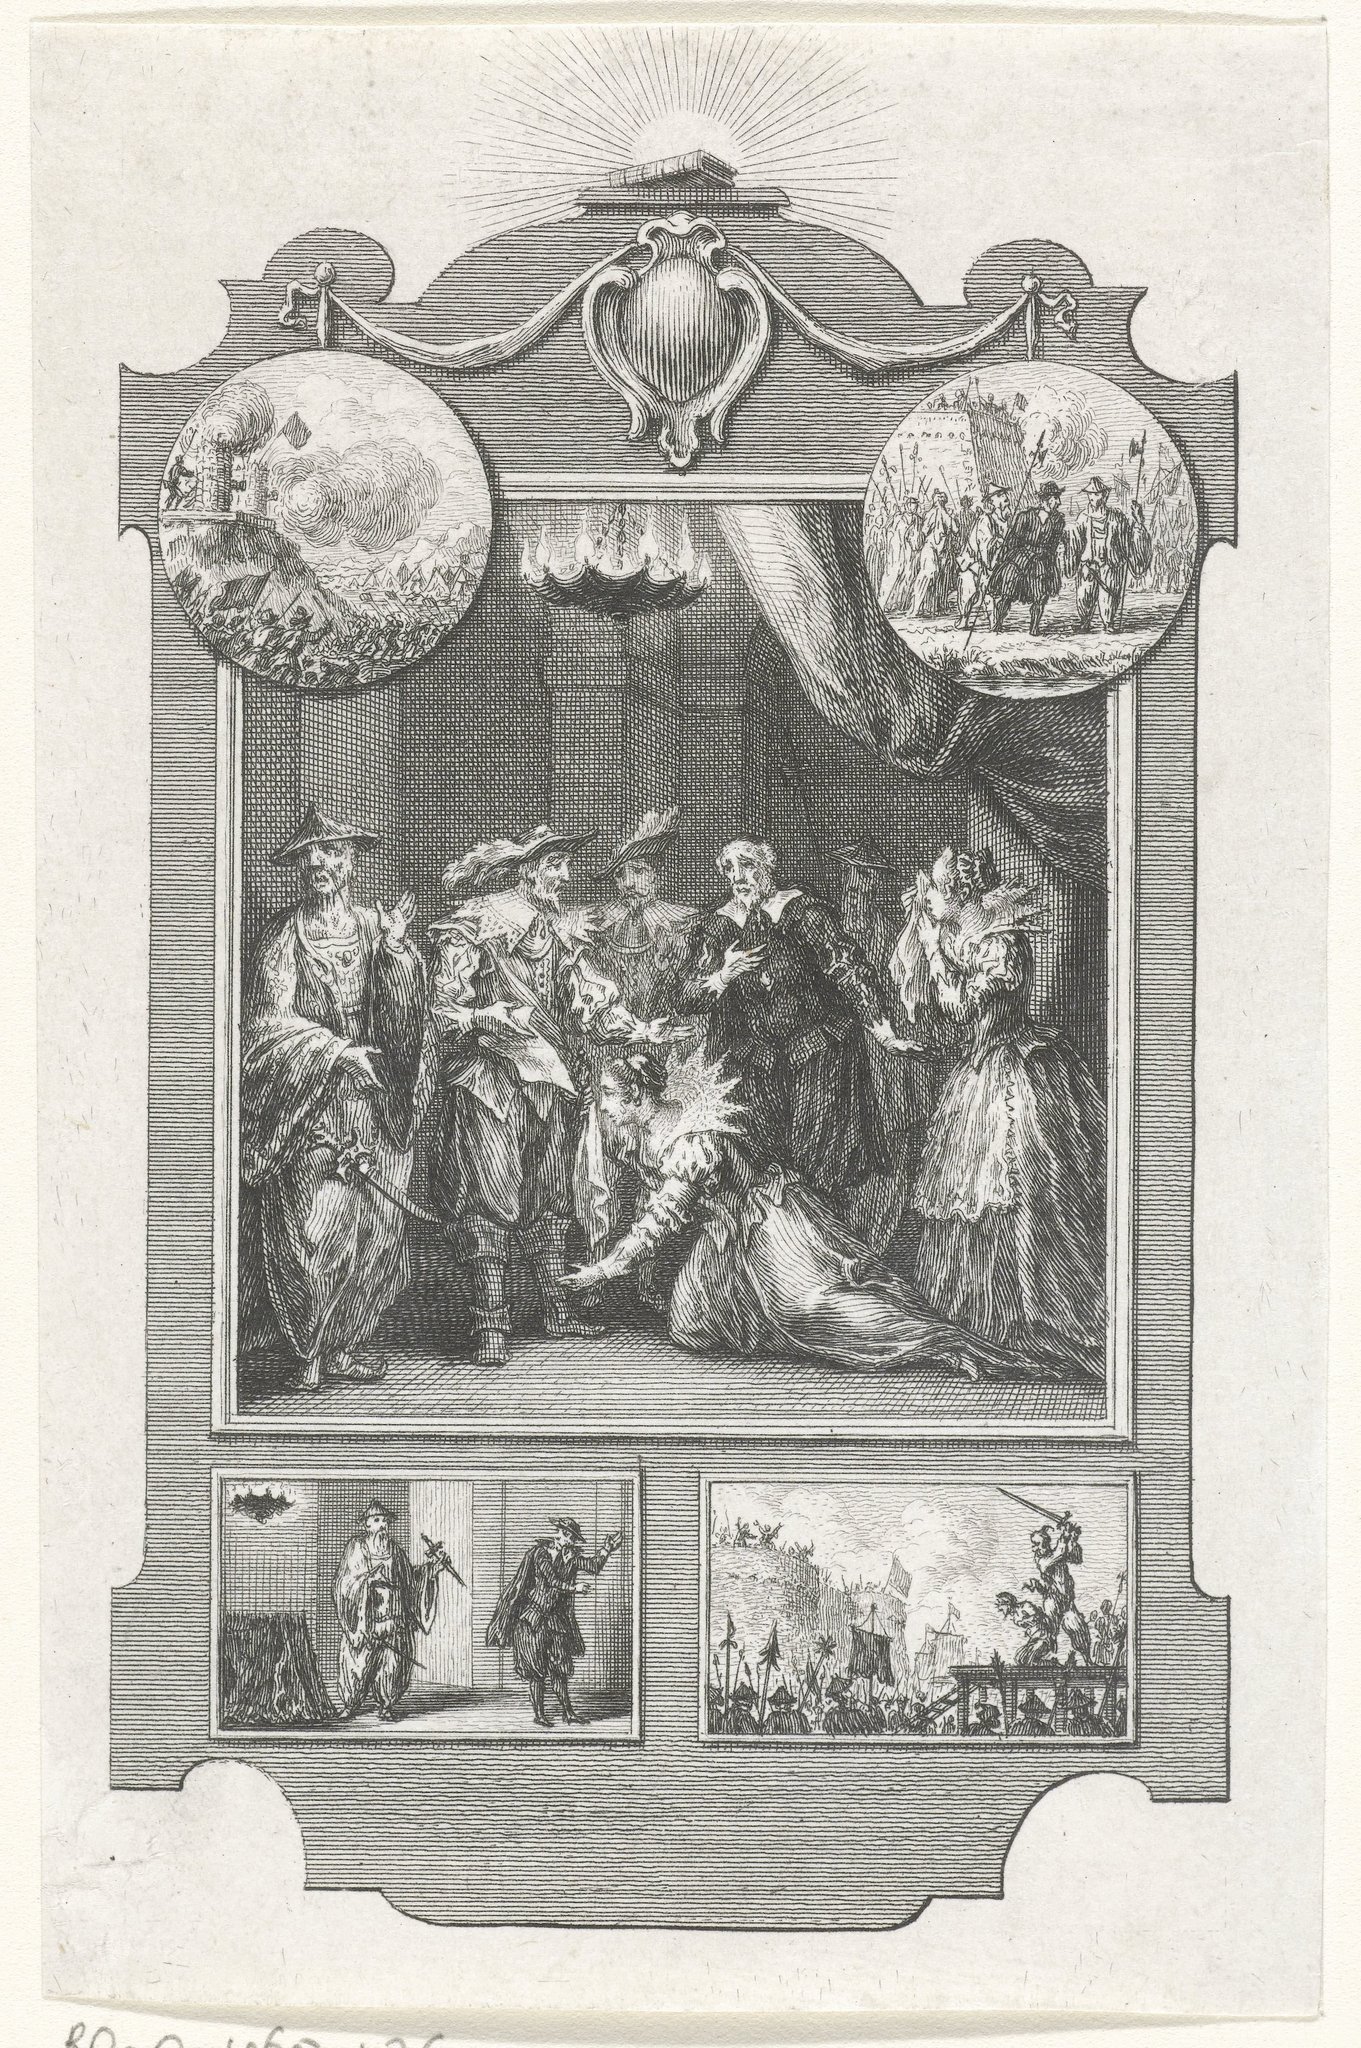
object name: print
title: Illustraties vaderlandse geschiedenis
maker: simon fokke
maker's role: draughtsman, print maker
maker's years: 1712-1784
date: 1722-1784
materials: paper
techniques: etching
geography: amsterdam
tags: chinese, weeping, kneeling figure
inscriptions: collector's mark: Lugt 2228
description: Voorstelling uit de vaderlandse geschiedenis. Een rijk geklede vrouw knielt met een zakdoek in haar hand voor een groep edelen en Chinezen. Deze centrale voorstelling wordt omringd door vier kleine beeltenissen van historische gebeurtenissen waarin het Chinese volk een rol speelt.